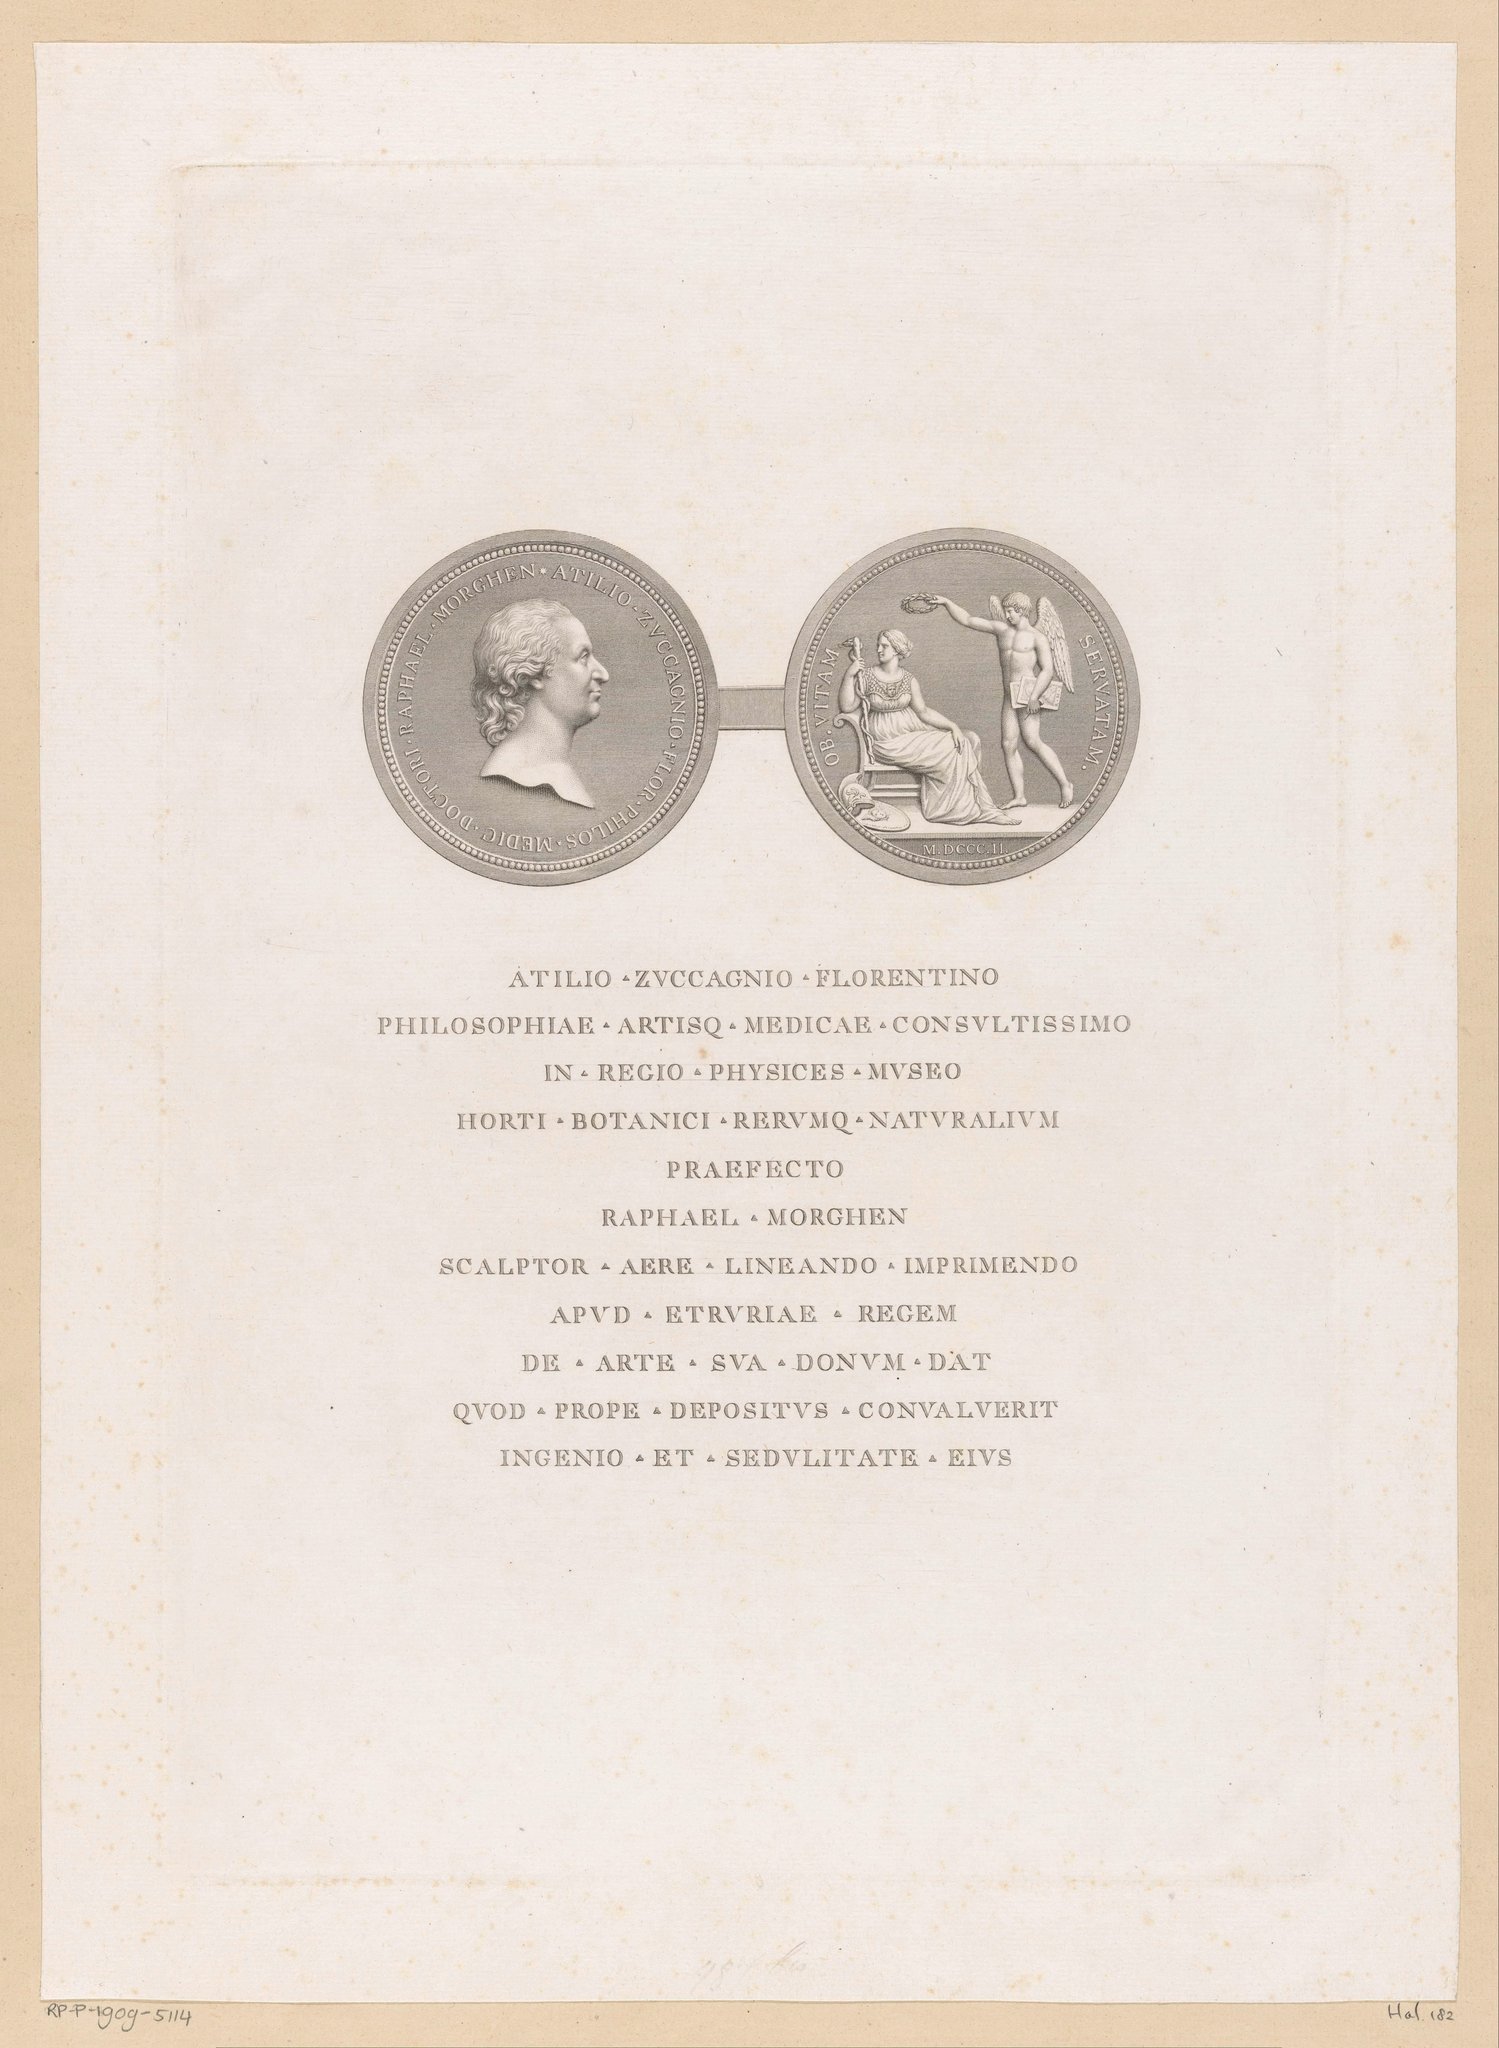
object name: print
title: Voor- en achterzijde van een munt met portret van filosoof en botanicus Attilio Zuccagni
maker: raphael morghen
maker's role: draughtsman, painter, print maker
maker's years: 1758-1833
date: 1802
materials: paper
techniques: engraving, etching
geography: italy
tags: historical persons, coin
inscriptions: date